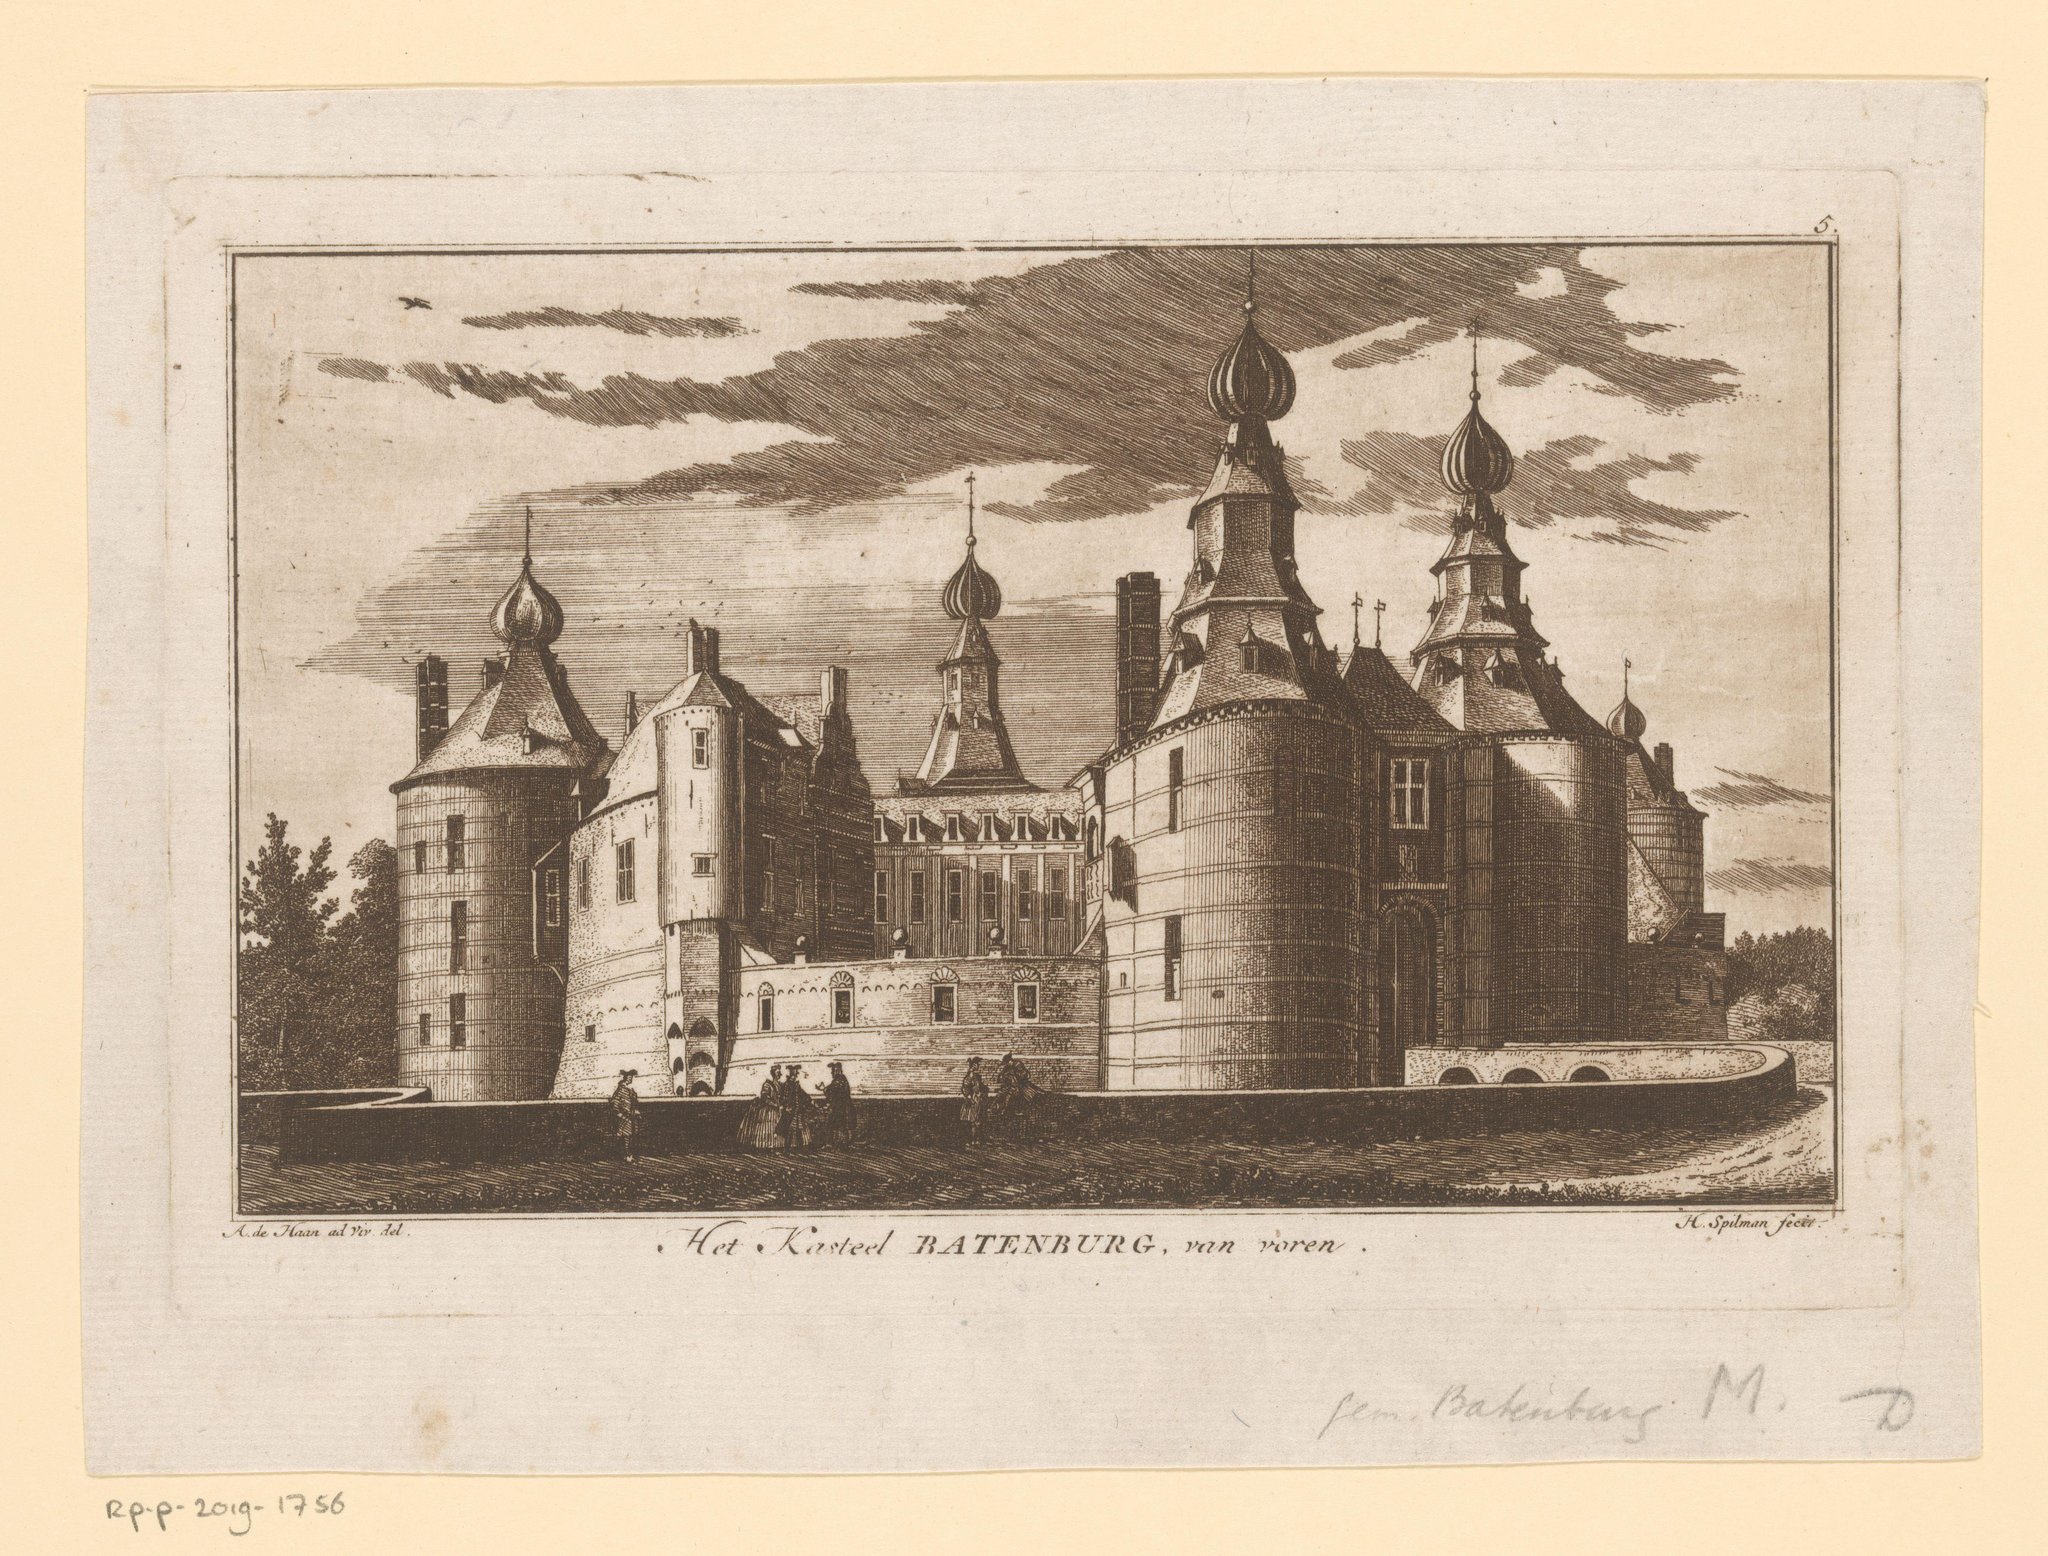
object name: print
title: Gezichten op dorpen en kastelen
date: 1740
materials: paper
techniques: etching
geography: haarlem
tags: castle